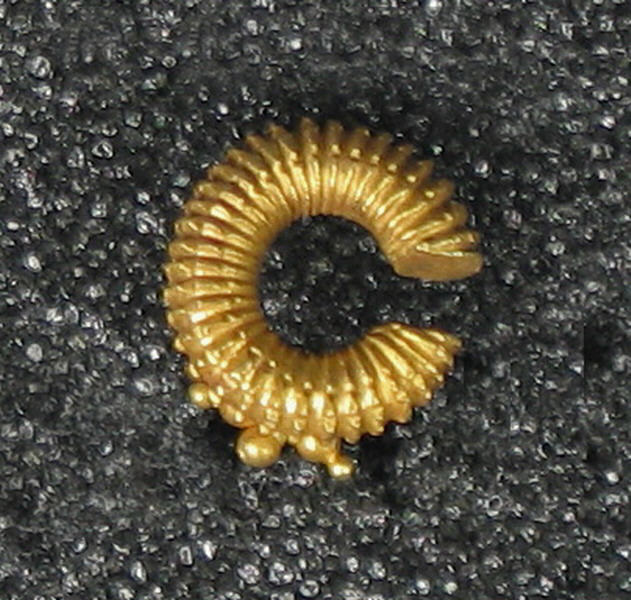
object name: earring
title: Cast Earring with Granulation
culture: indonesian, central java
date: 701-1200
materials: gold